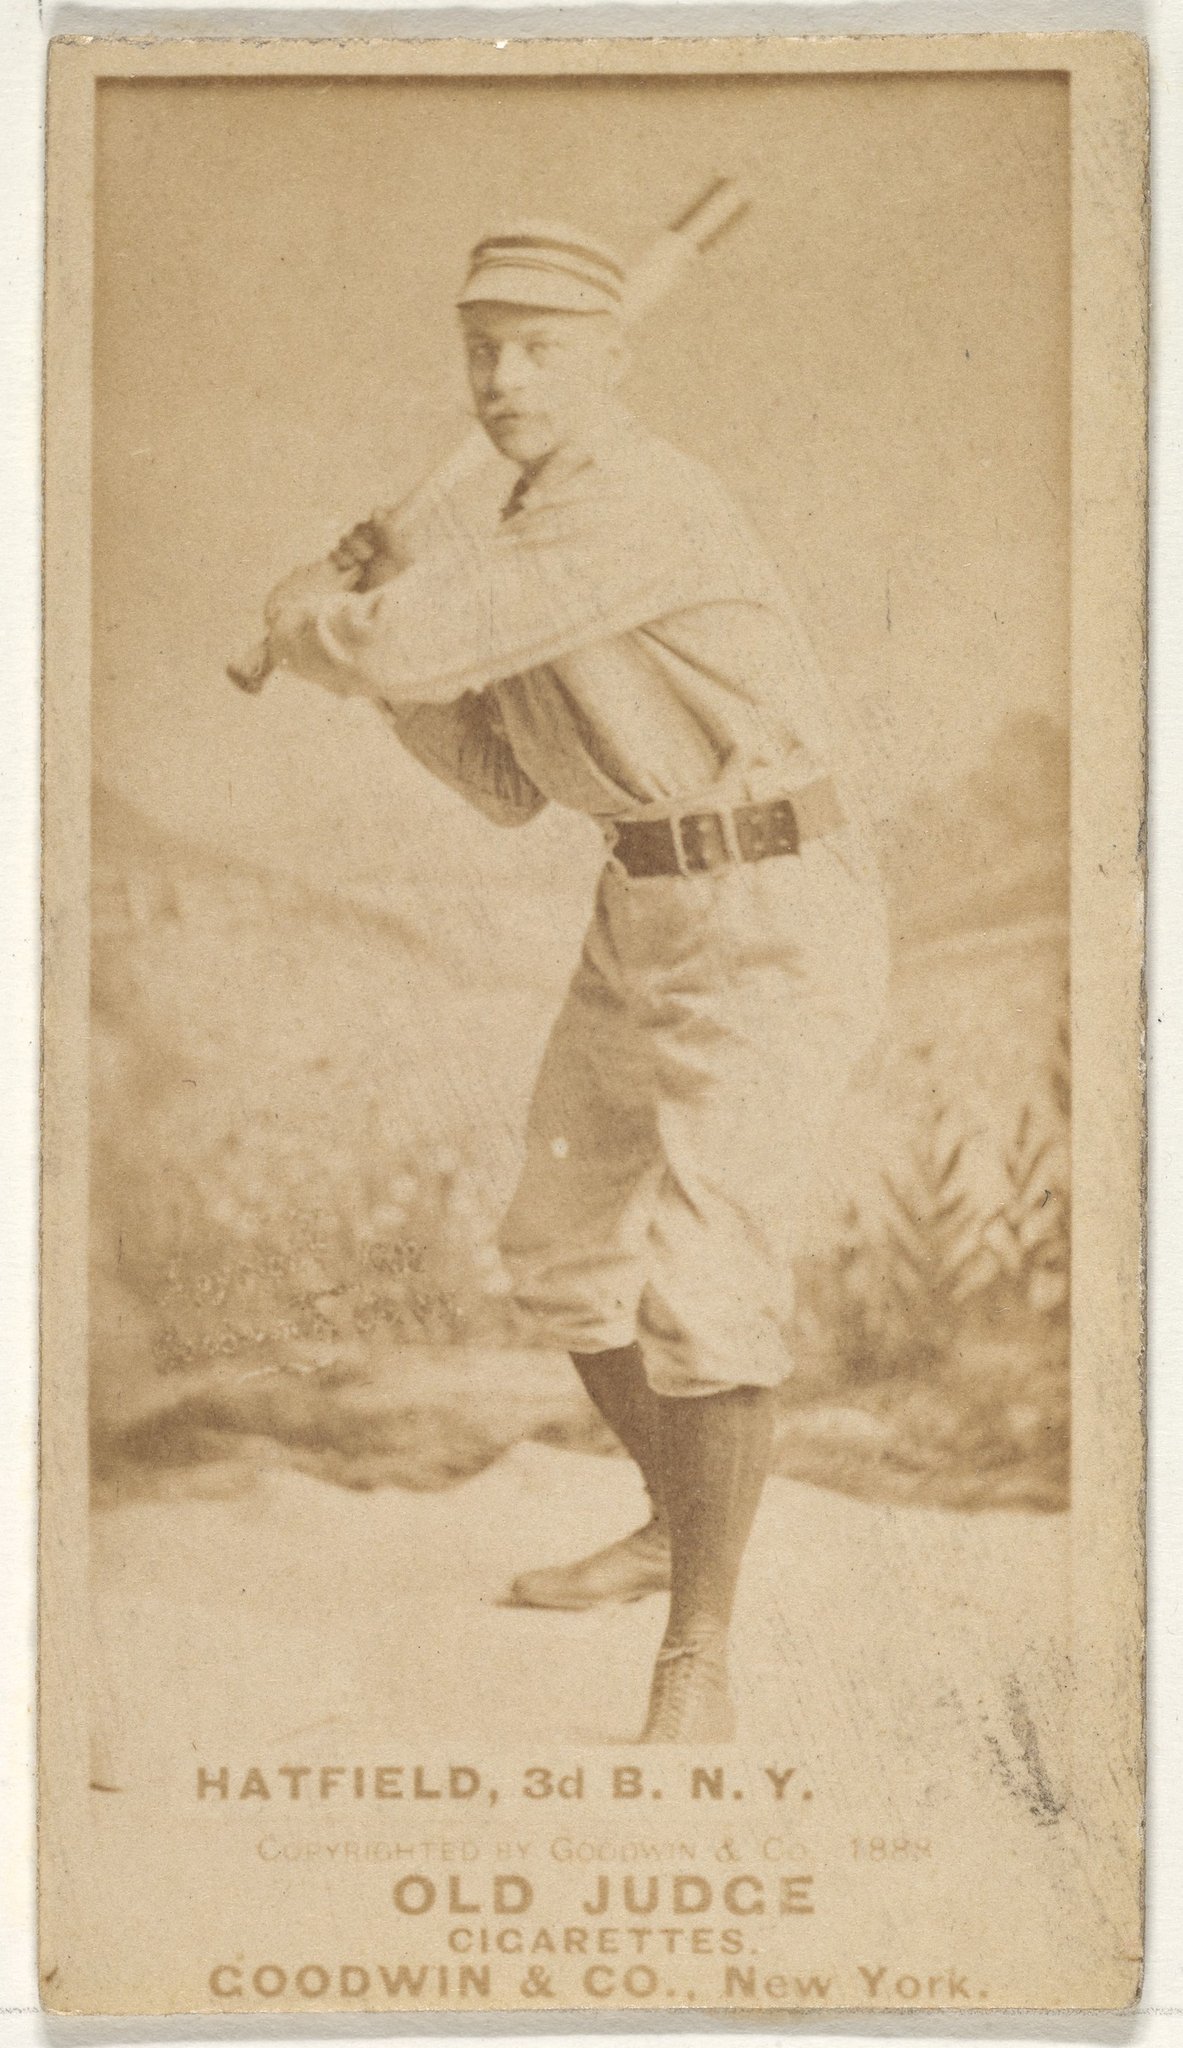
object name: baseball card, photograph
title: Gil Hatfield, 3rd Base, New York, from the Old Judge series (N172) for Old Judge Cigarettes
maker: goodwin & company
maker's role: publisher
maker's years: 1850-1950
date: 1888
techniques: albumen silver print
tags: men,portraits,baseball,athletes